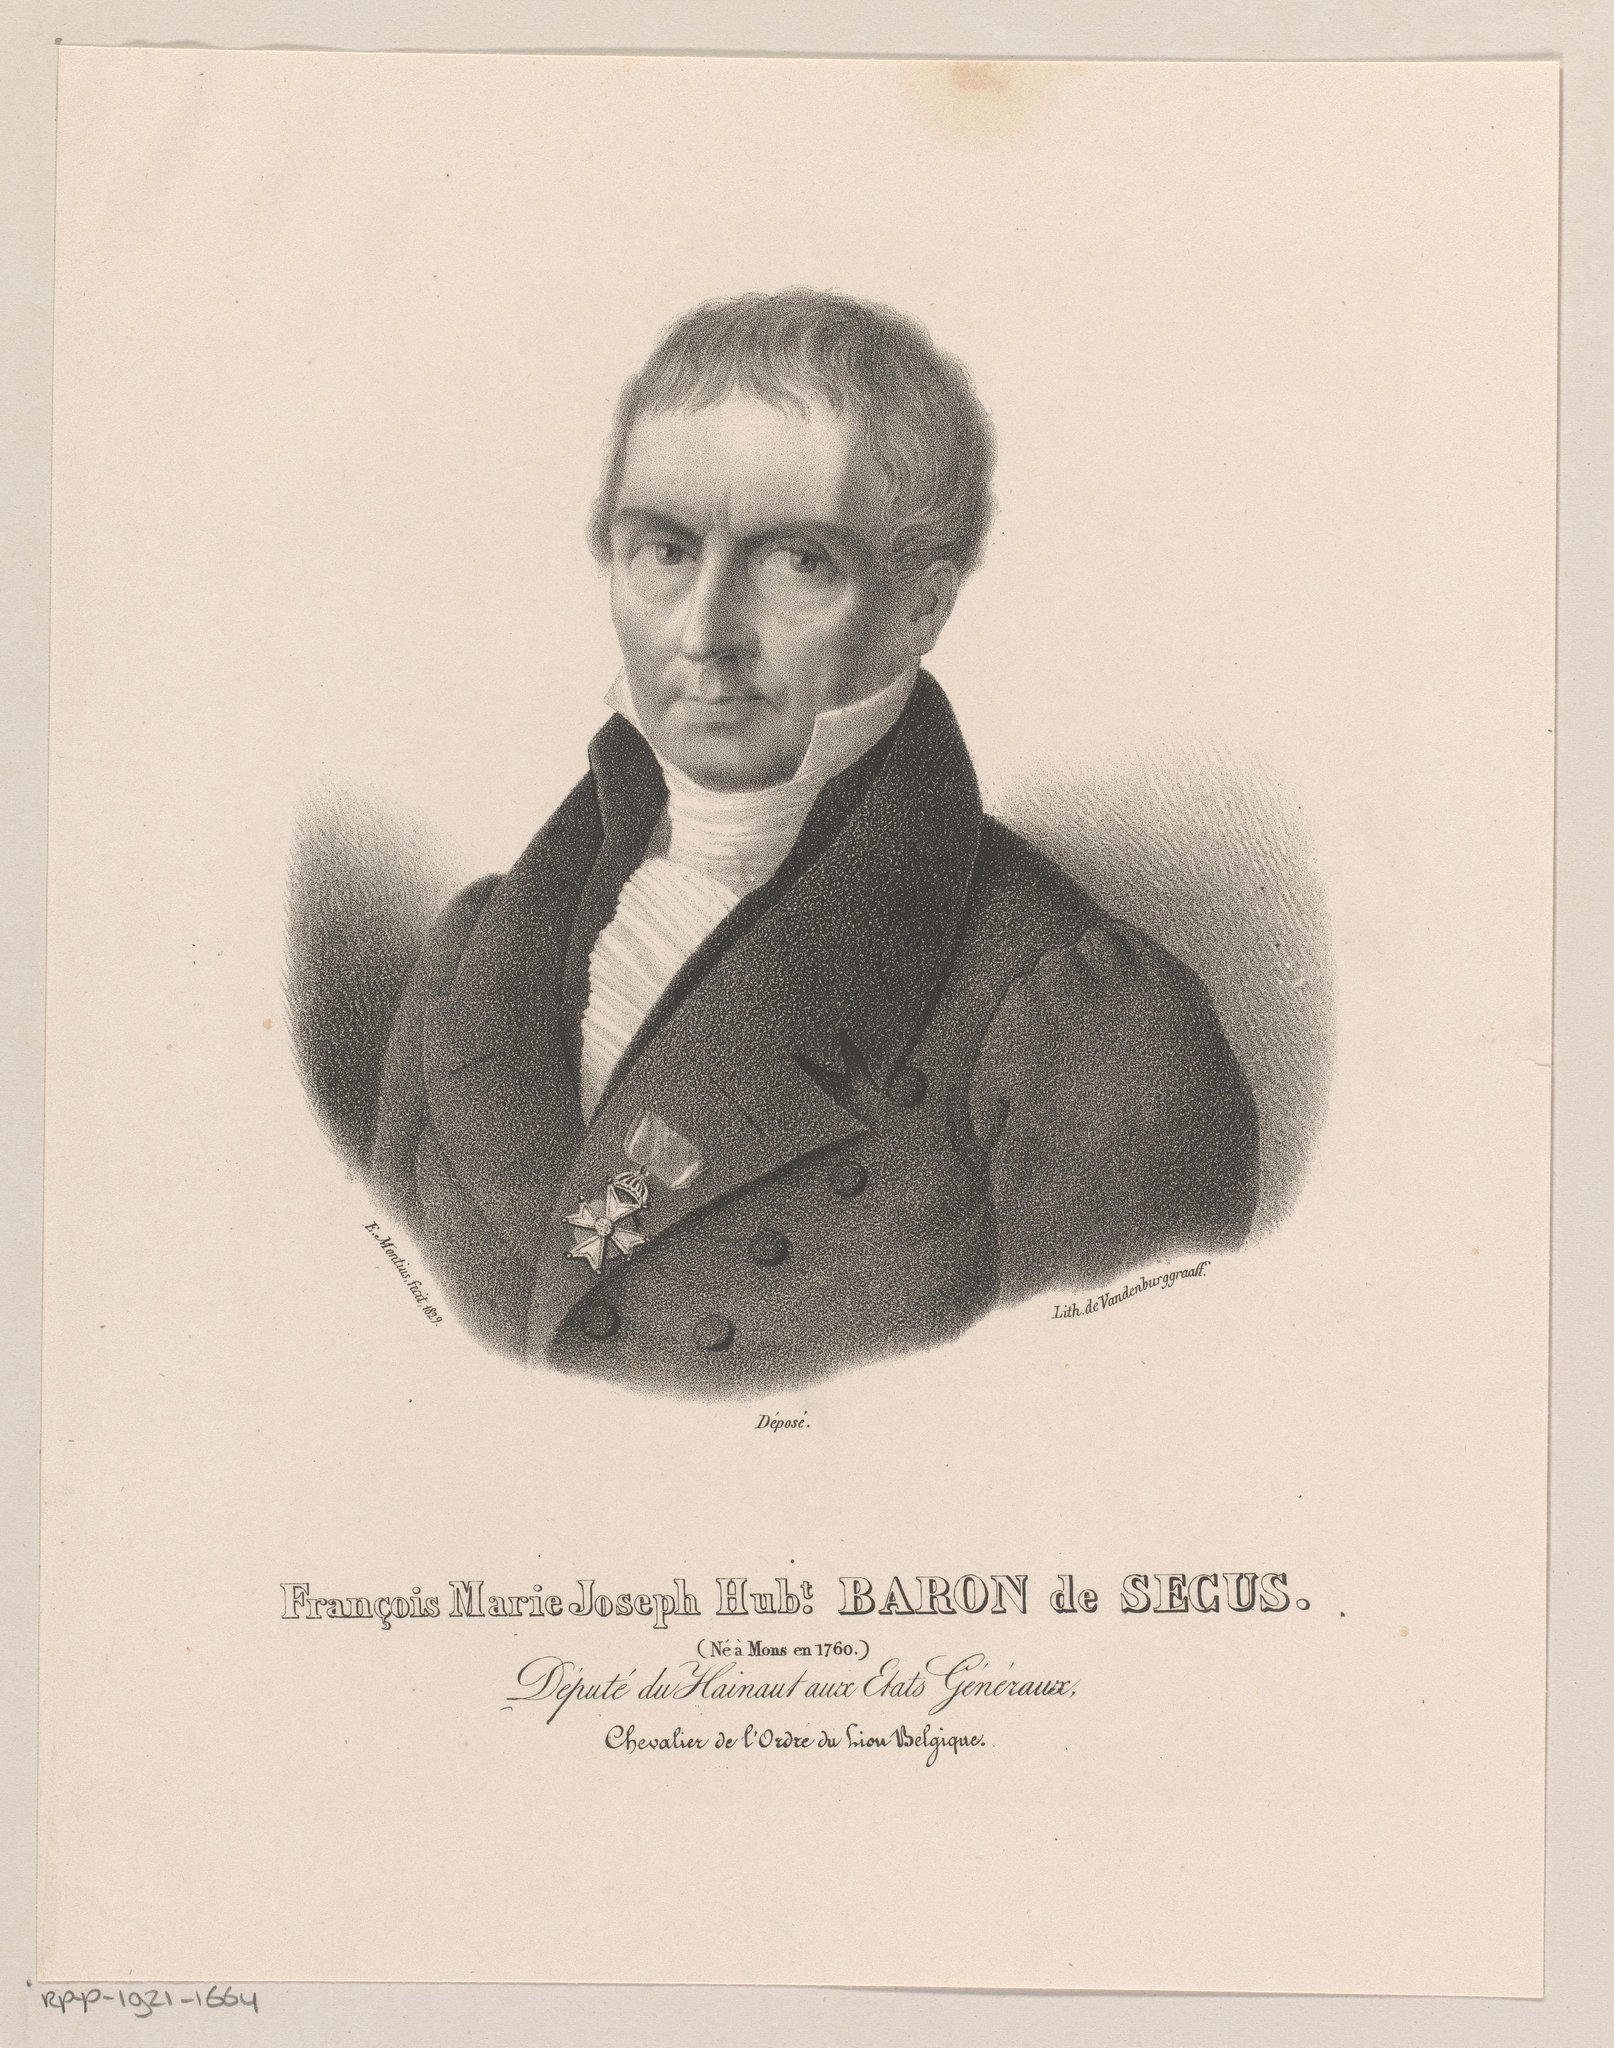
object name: print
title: Portret van François de Sécus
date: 1829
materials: paper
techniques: lithograph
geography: brussels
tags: historical persons, politician, e.g. party leader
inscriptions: collector's mark: Lugt 2233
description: Met vierregelig onderschrift in het Frans.